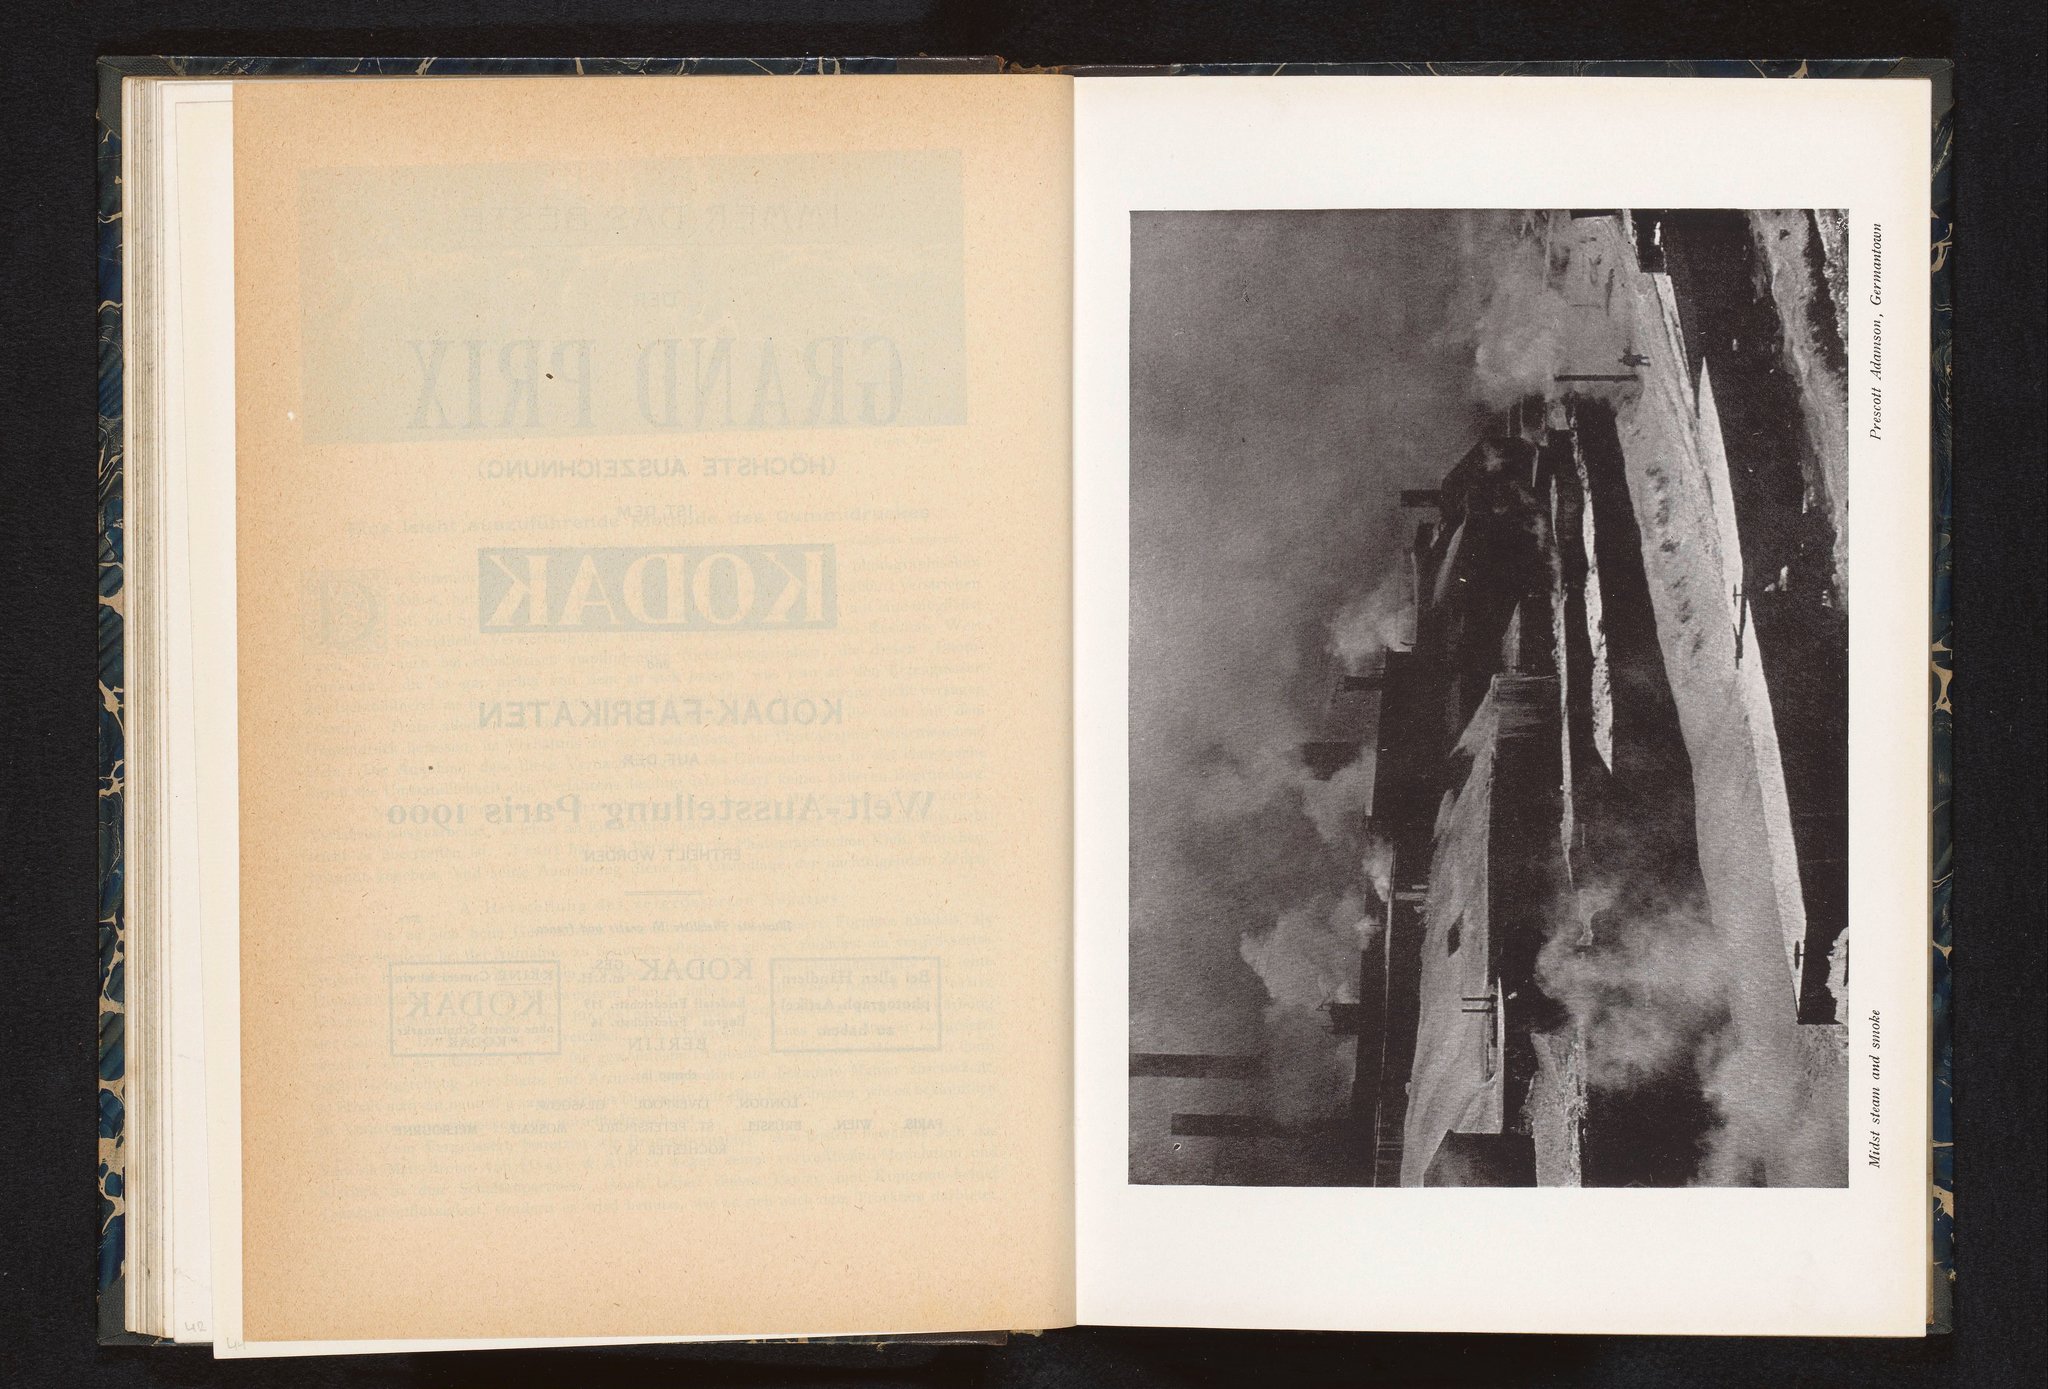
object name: photomechanical print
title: Midst steam and smoke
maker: prescott adamson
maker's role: fotograaf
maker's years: 1866-1933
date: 1896-1901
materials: paper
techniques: autotype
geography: berlin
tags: factory-building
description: Prent op tweede ongenummerde pagina na pagina 56.